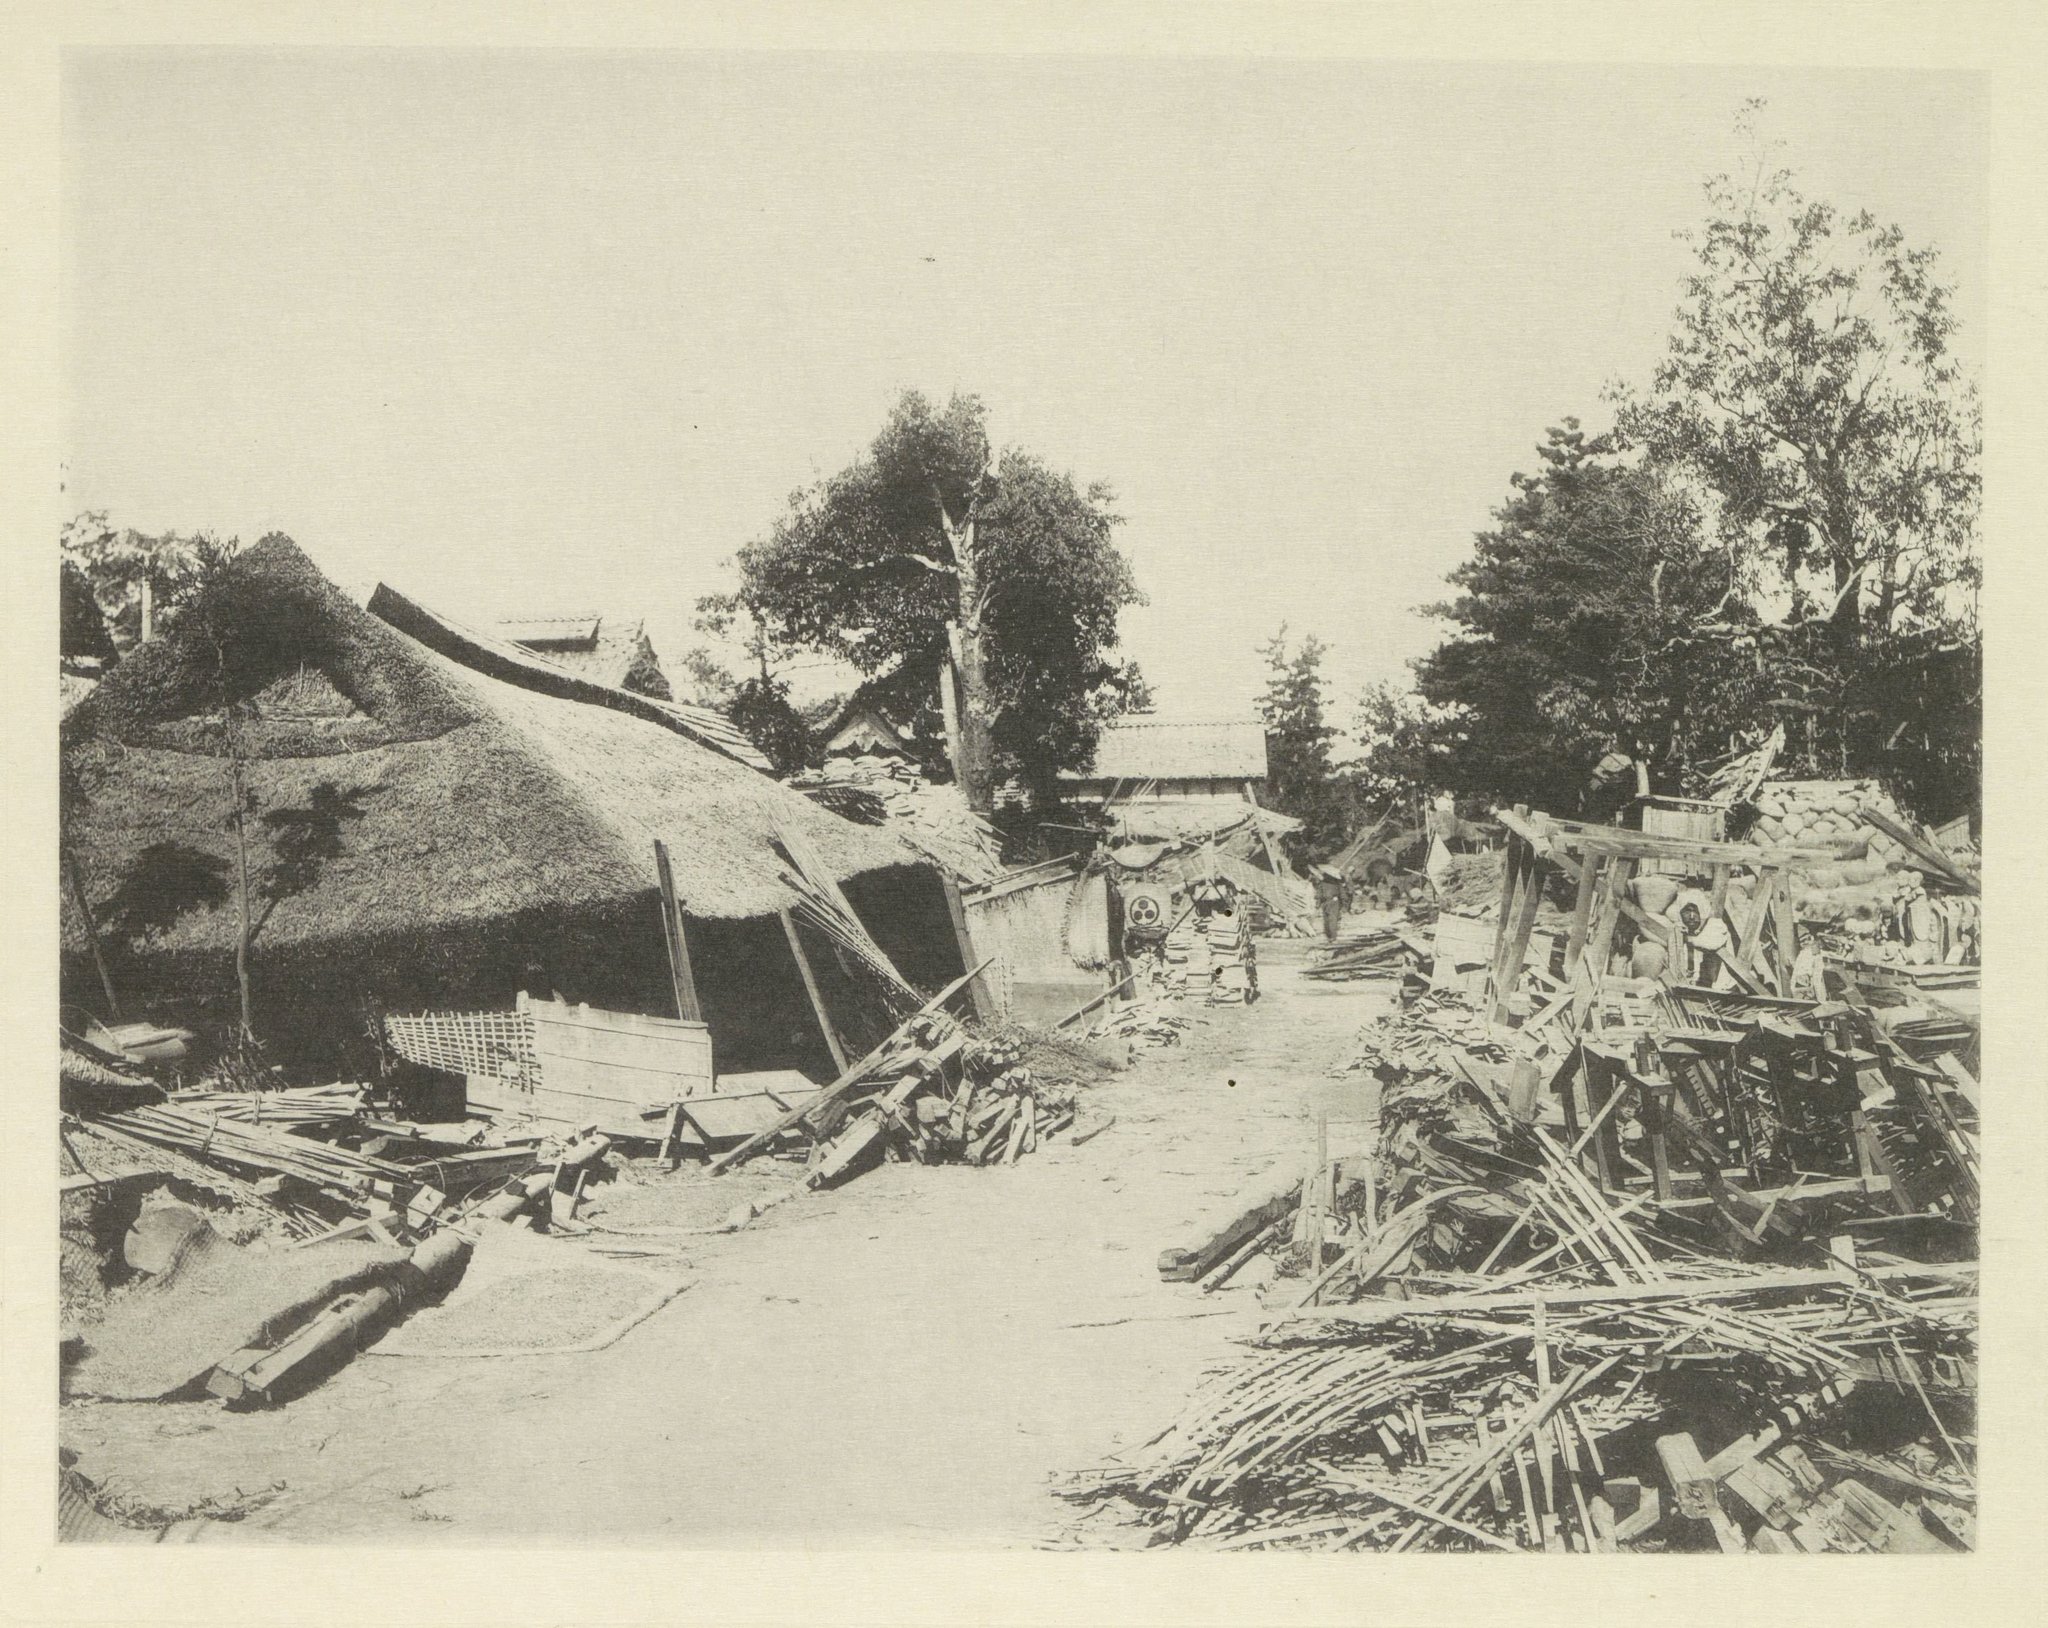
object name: photomechanical print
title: Verwoeste gebouwen langs de weg naar Gifu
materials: paper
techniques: photograph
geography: japan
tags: ruin of a building ~ architecture, consequences of an earthquake, public road